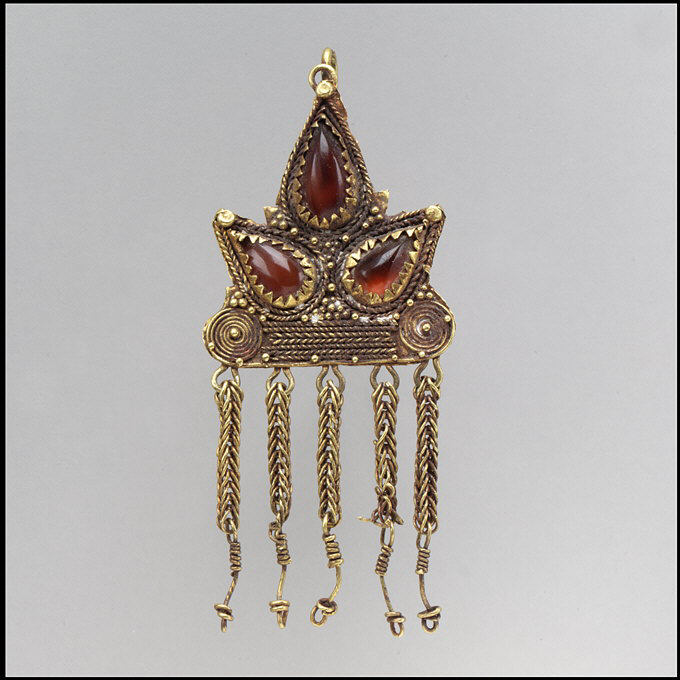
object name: earring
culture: sarmatian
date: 34-66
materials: gold, gemstone